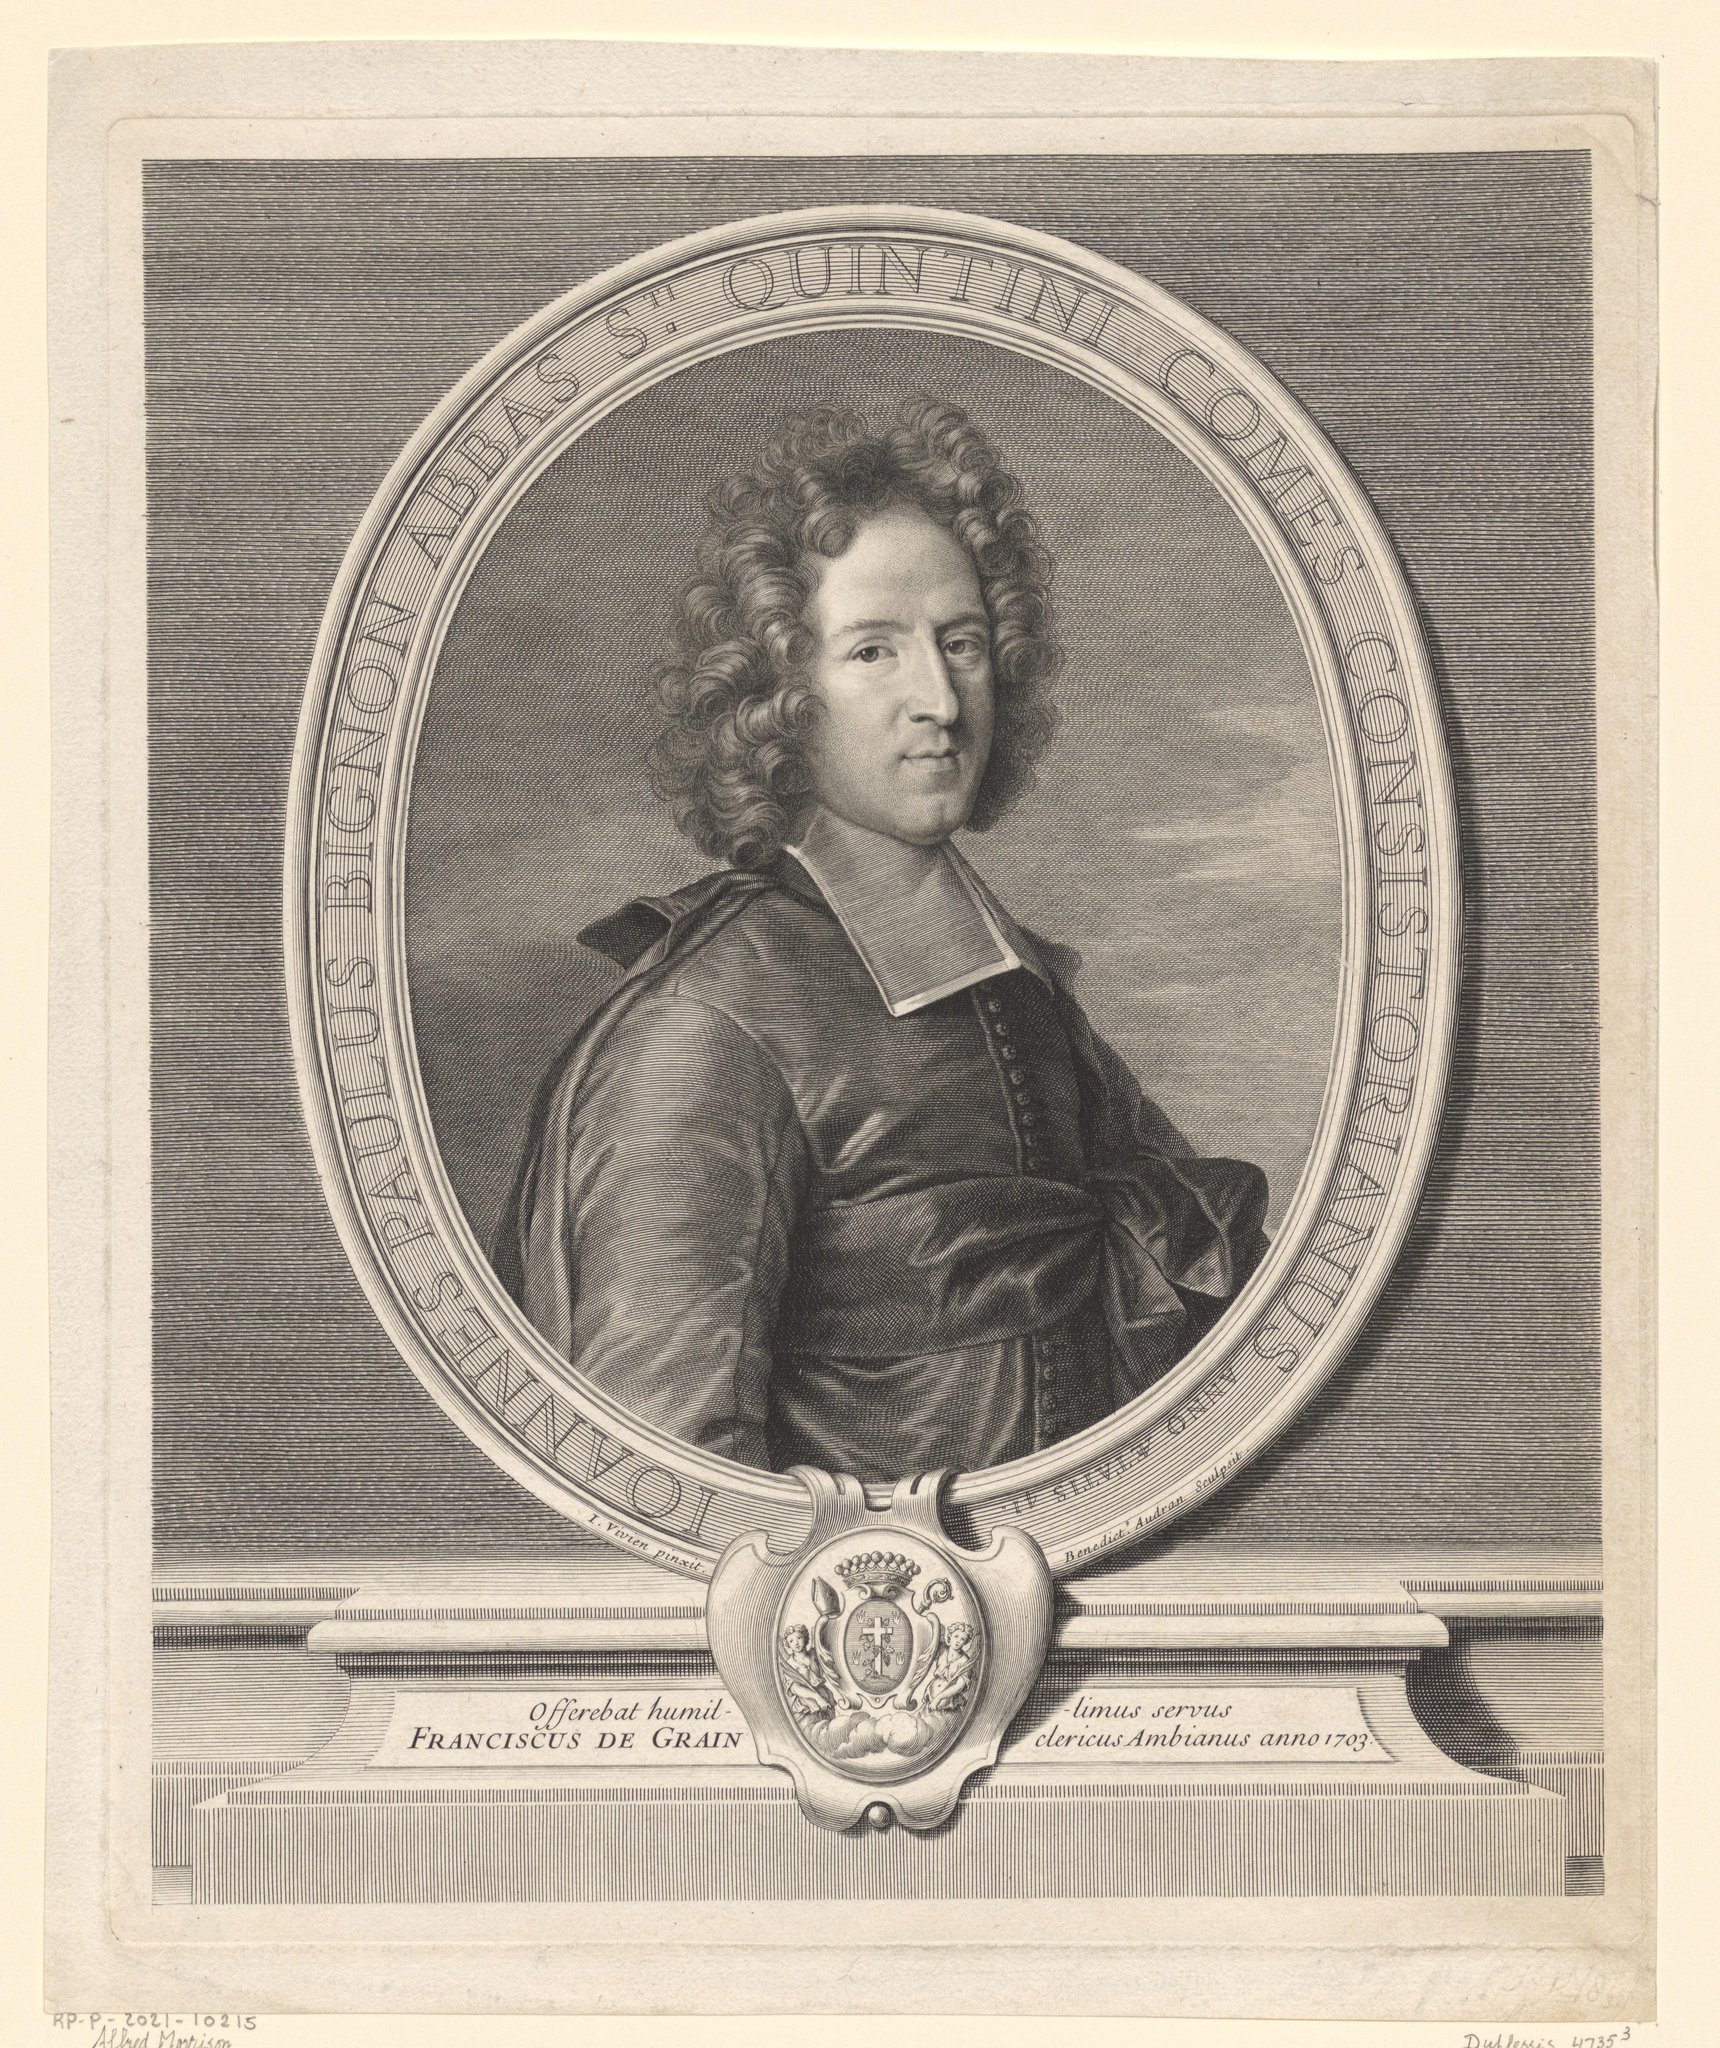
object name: print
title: Joannes Paulus Bignon abbas Sti. Quintini (...)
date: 1703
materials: paper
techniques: engraving, etching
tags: paris, jean-paul bignon, abbot, historical persons, armorial bearing, heraldry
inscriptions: collector's mark: Lugt 151